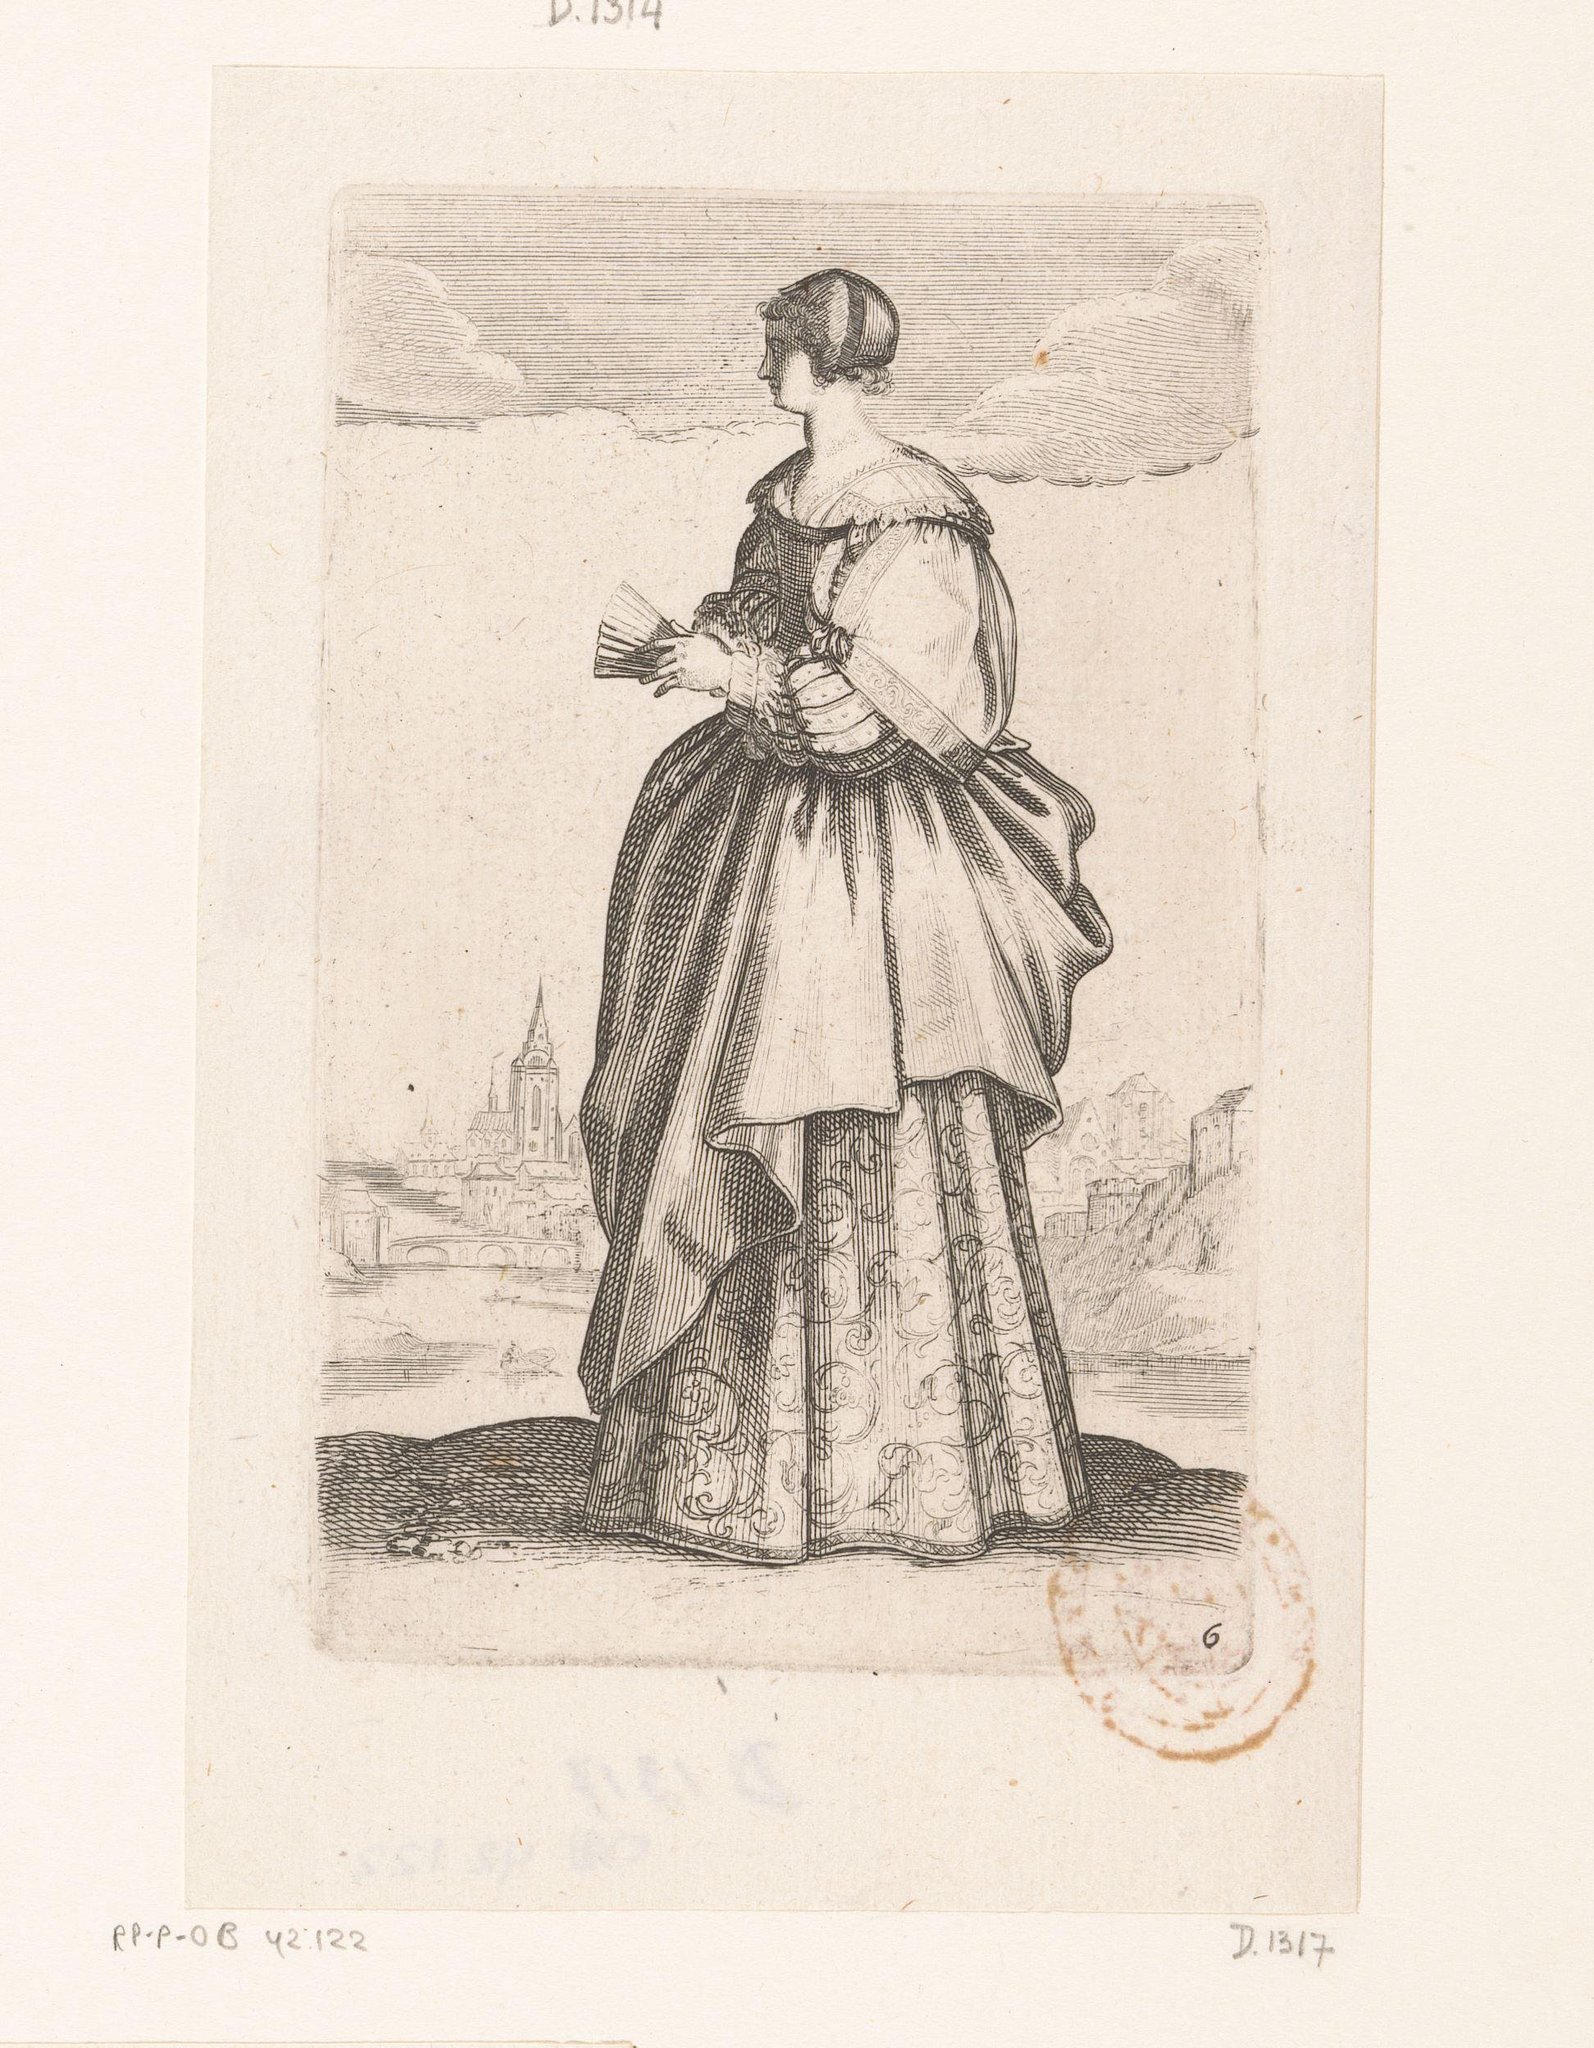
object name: costume print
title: Franse edelvrouw met vouwwaaier, gekleed volgens de mode van ca. 1630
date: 1629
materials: paper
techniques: engraving, etching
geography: paris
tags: skirt (underskirt) (+ women's clothes), styles of hairdress - aa - ~ women, head-gear: cap (+ women's clothes), neck-gear: collar (+ women's clothes), clothes, costume (+ women's clothes), skirt (+ women's clothes), sleeves: cuffs (+ women's clothes), dress, gown (+ women's clothes), fan (+ women's clothes), sleeves (+ women's clothes), clothing for the upper part of the body (with name) (+ women's clothes)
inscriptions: collector's mark: Lugt 240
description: Maakt deel uit van een serie met twintig kostuumprenten van Franse edellieden naar ontwerp van Abraham Bosse en Jean de Saint-Igny, in 1629 uitgegeven door Melchior Tavernier en een tweede staat door François Langlois.